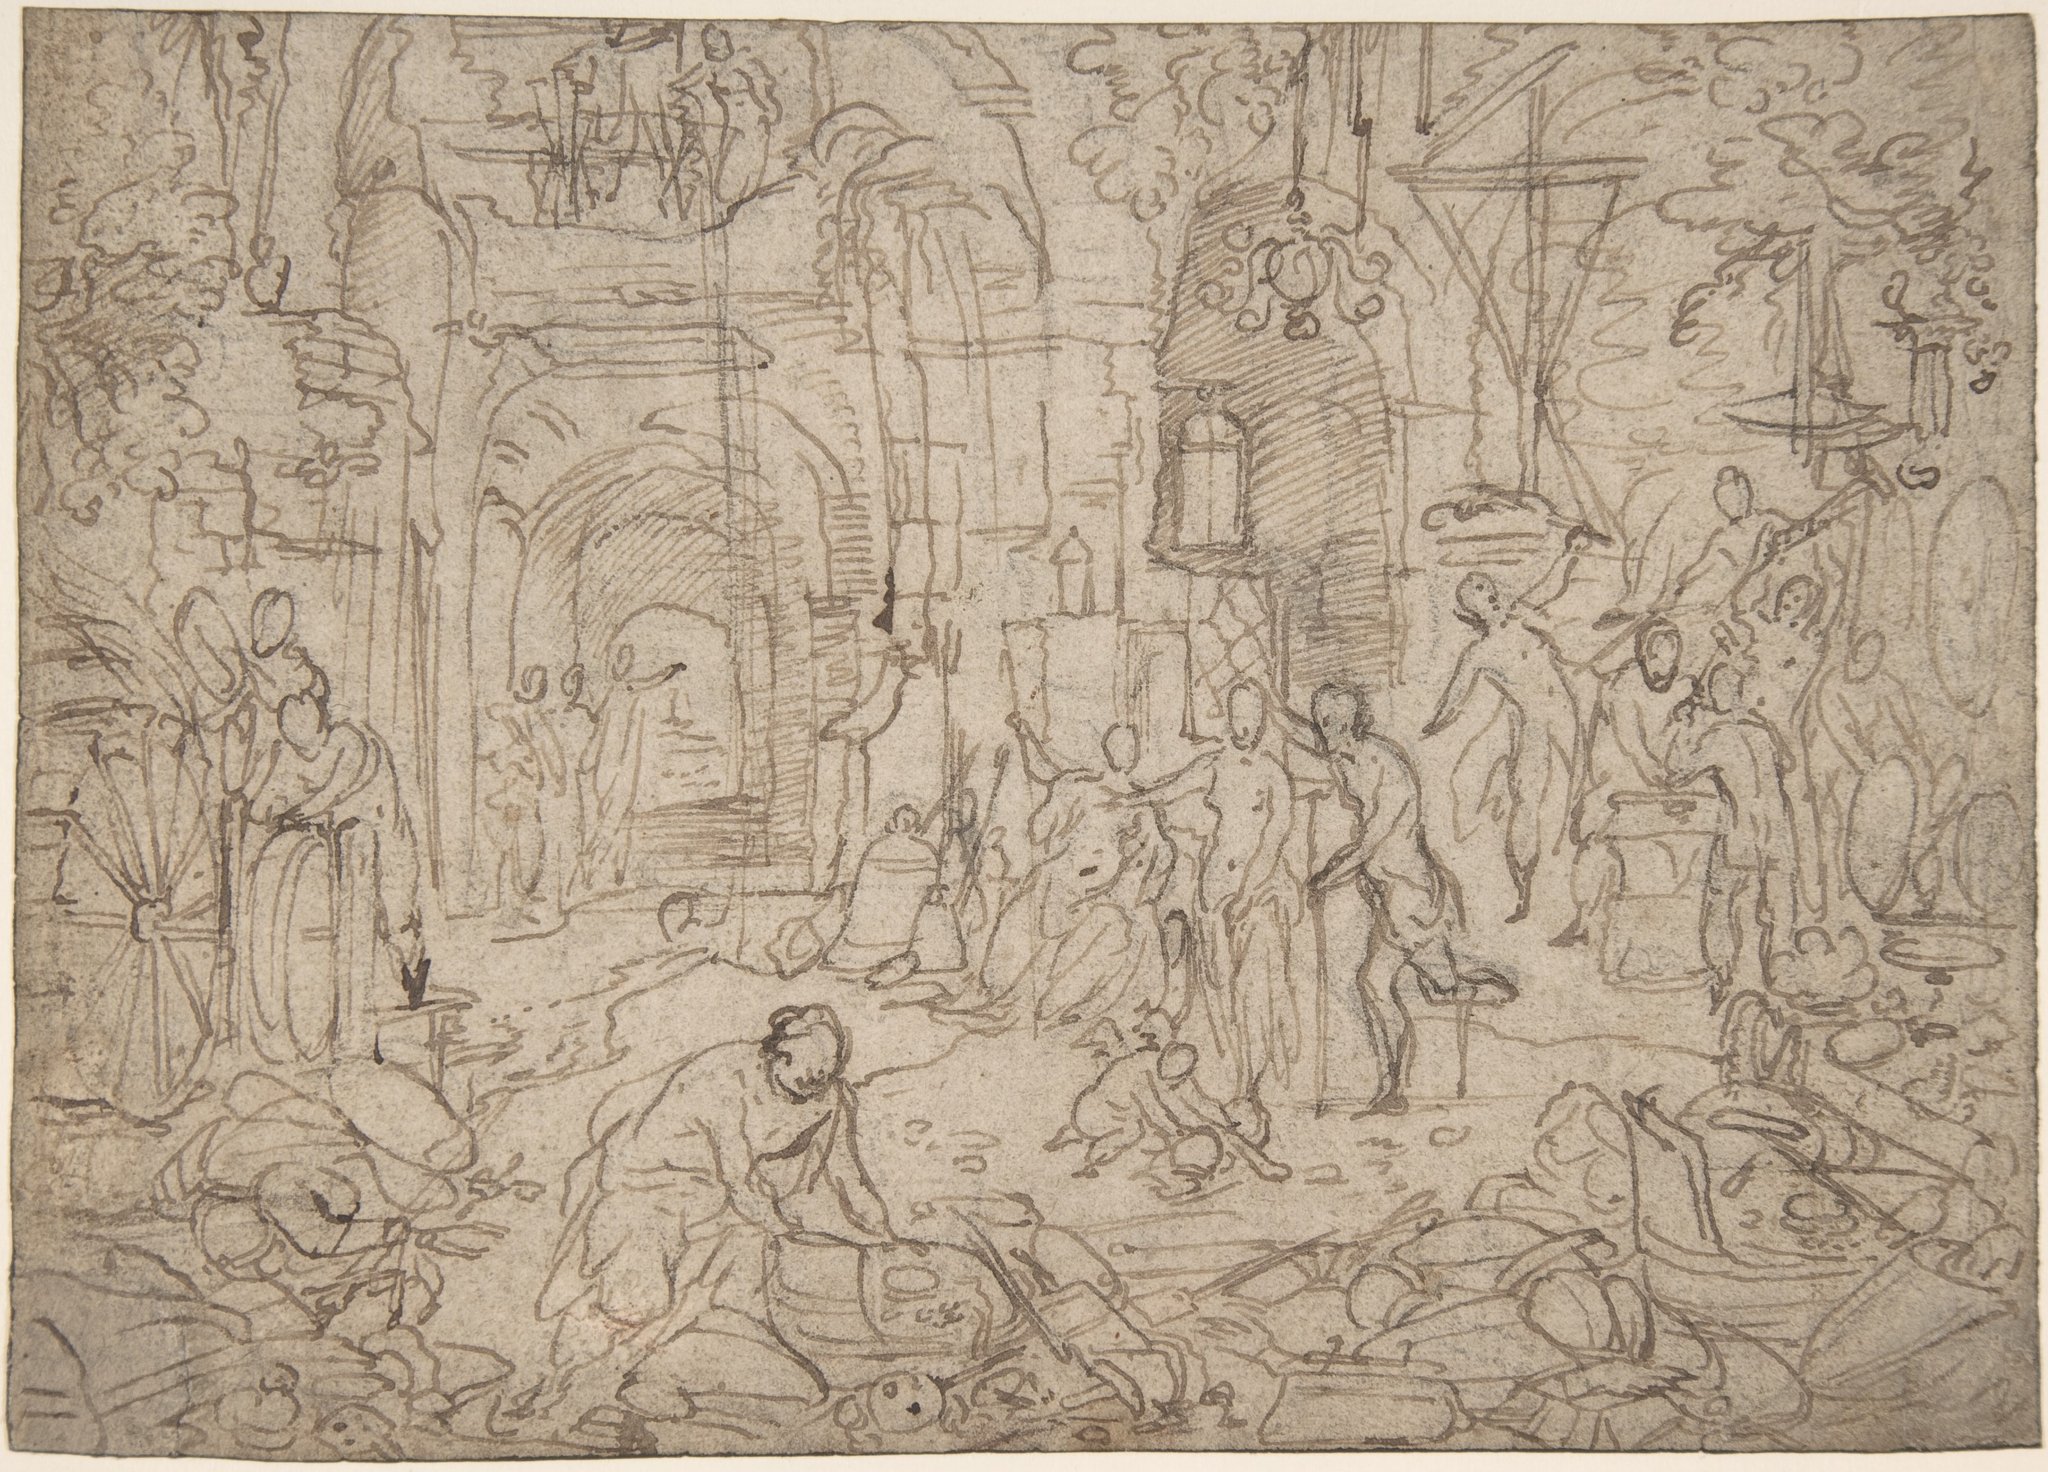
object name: drawing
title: Venus Visiting the Forge of Vulcan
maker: pauwels franck, called paolo fiammingo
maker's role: artist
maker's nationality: flemish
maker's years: 1540-1596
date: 1501-1600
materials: chalk, ink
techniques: pen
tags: human figures,venus,vulcan